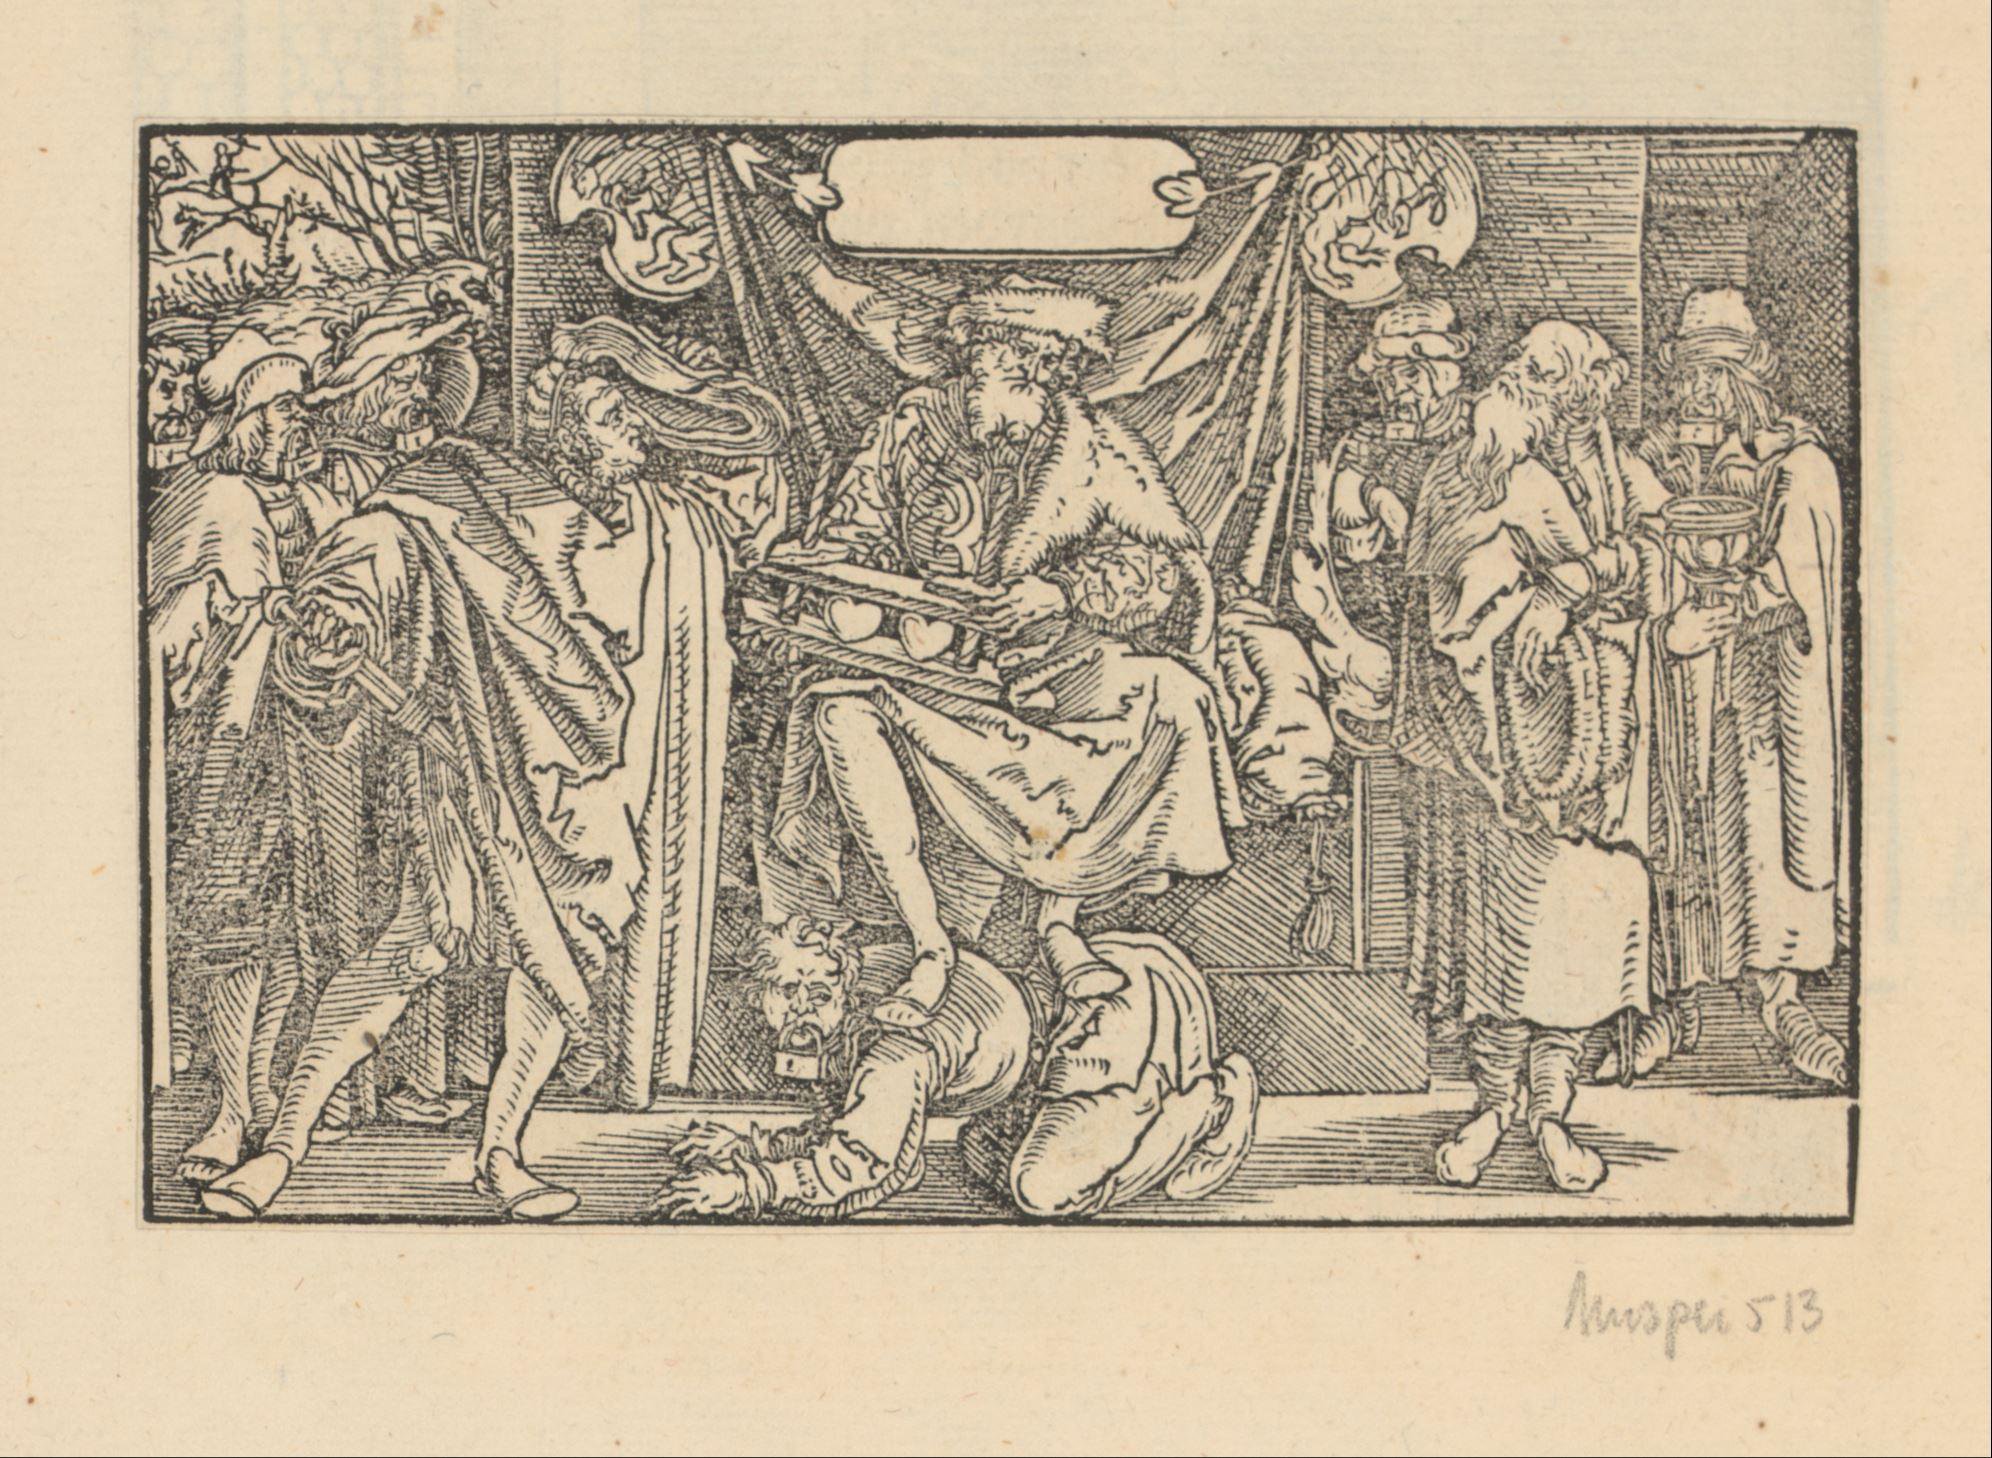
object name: album leaf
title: Tiran op zijn troon terwijl een man een zwaard trekt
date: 1514-1531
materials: paper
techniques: letterpress printing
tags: revolutionary council, attempt, political murder, dictatorial government, tyranny; 'tirannide' (ripa)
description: Deze prent is gebruikt in: Cicero, Marcus Tulius. Officia M.T.C. Ein Buch so Marcus Tullius Cicero der Römer zu seynem (...). [Vertaald uit het Latijn door] Johann von Schwarzenberg. Augsburg: Heinrich Steiner, 1531.